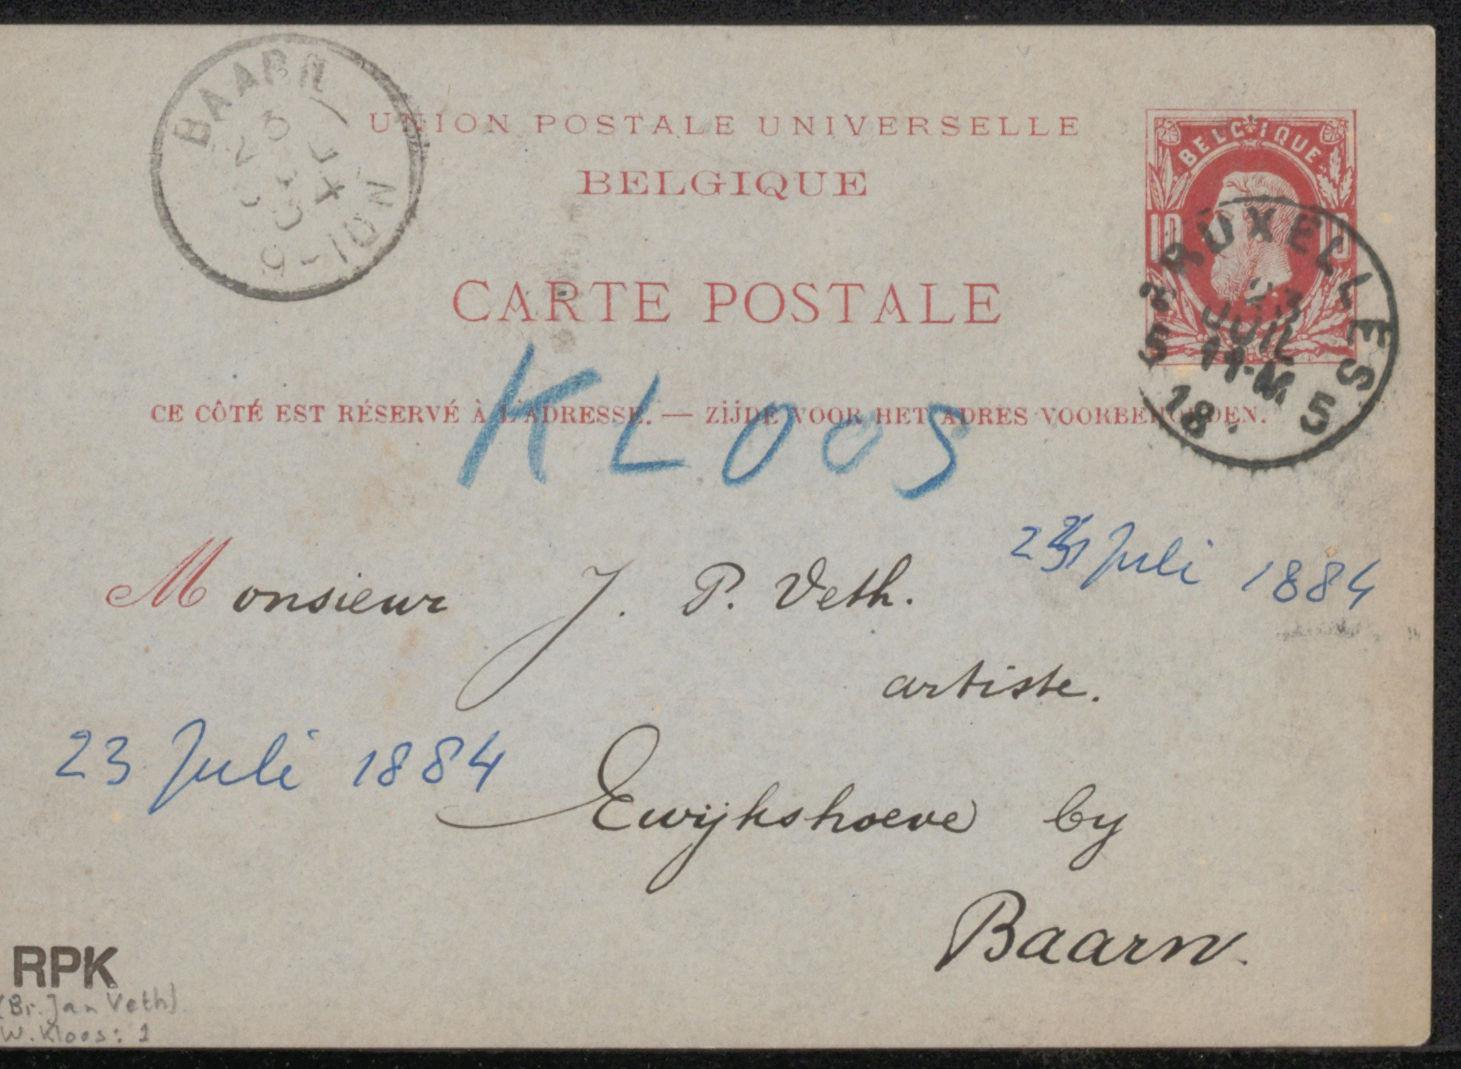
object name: postcard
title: Briefkaart aan Jan Veth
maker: willem kloos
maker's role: dichter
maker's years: 1859-1938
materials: cardboard, ink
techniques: pen, writing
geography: brussels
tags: painter, print maker, draughtsman, designer, jan veth, brussels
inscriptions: collector's mark: ‘RPK’